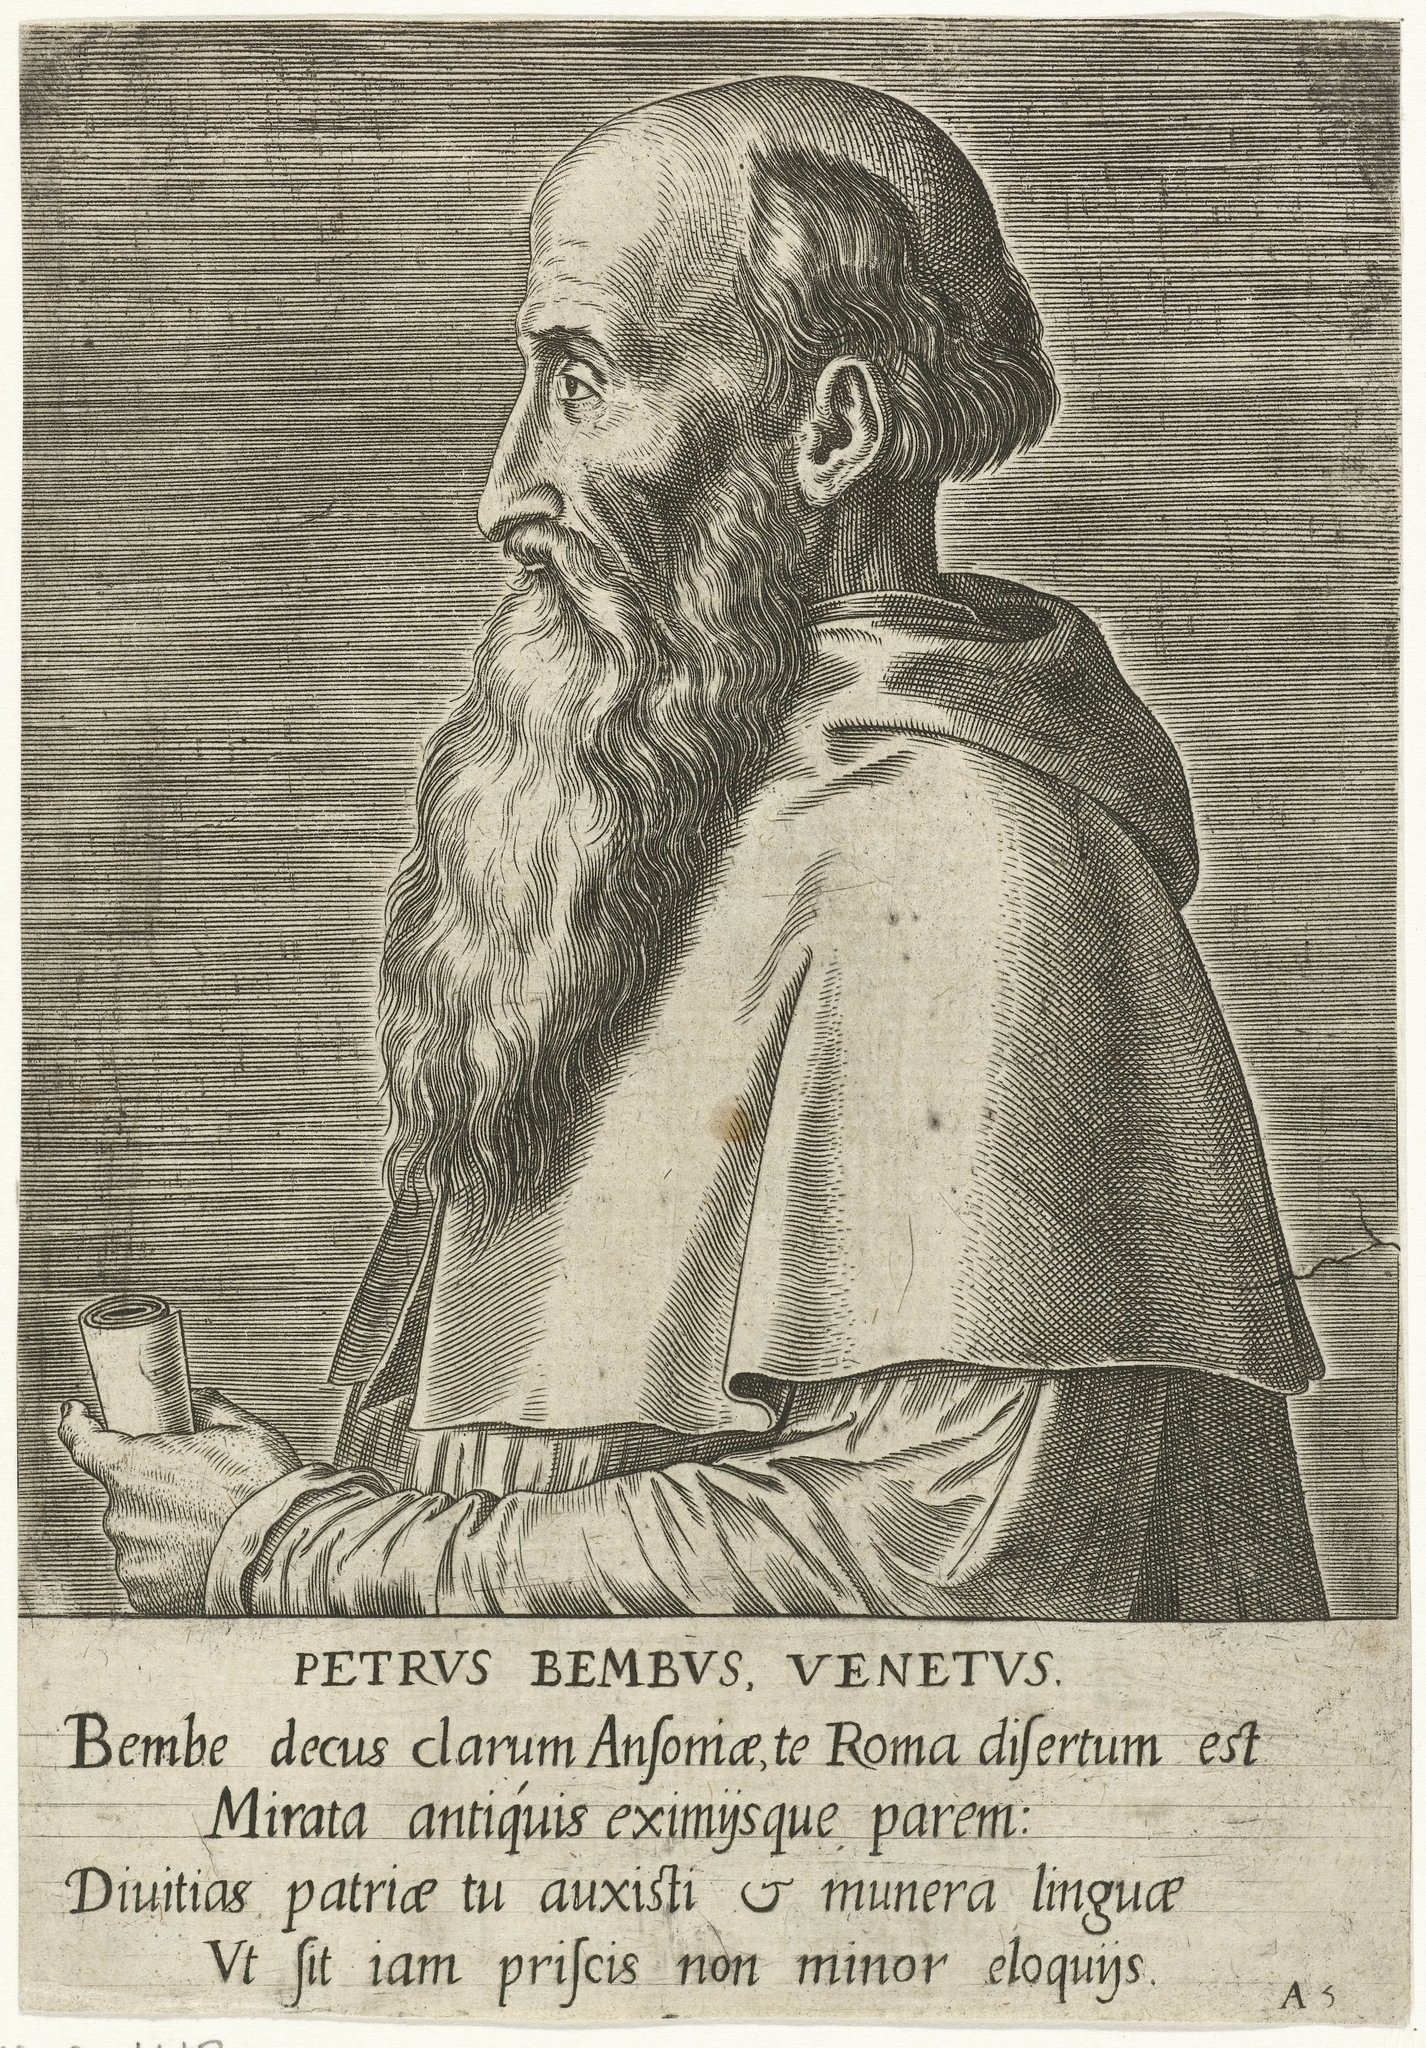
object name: print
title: Portretten van beroemde Europese geleerden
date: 1572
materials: paper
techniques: engraving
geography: venice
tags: venice, rome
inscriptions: collector's mark: Lugt 2228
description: Portret van Pietro Bembo, Italiaanse dichter en humanist. In profiel naar links. Genummerd A5. De prent heeft een Latijns onderschrift en maakt deel uit van een serie van beroemde Europese geleerden.